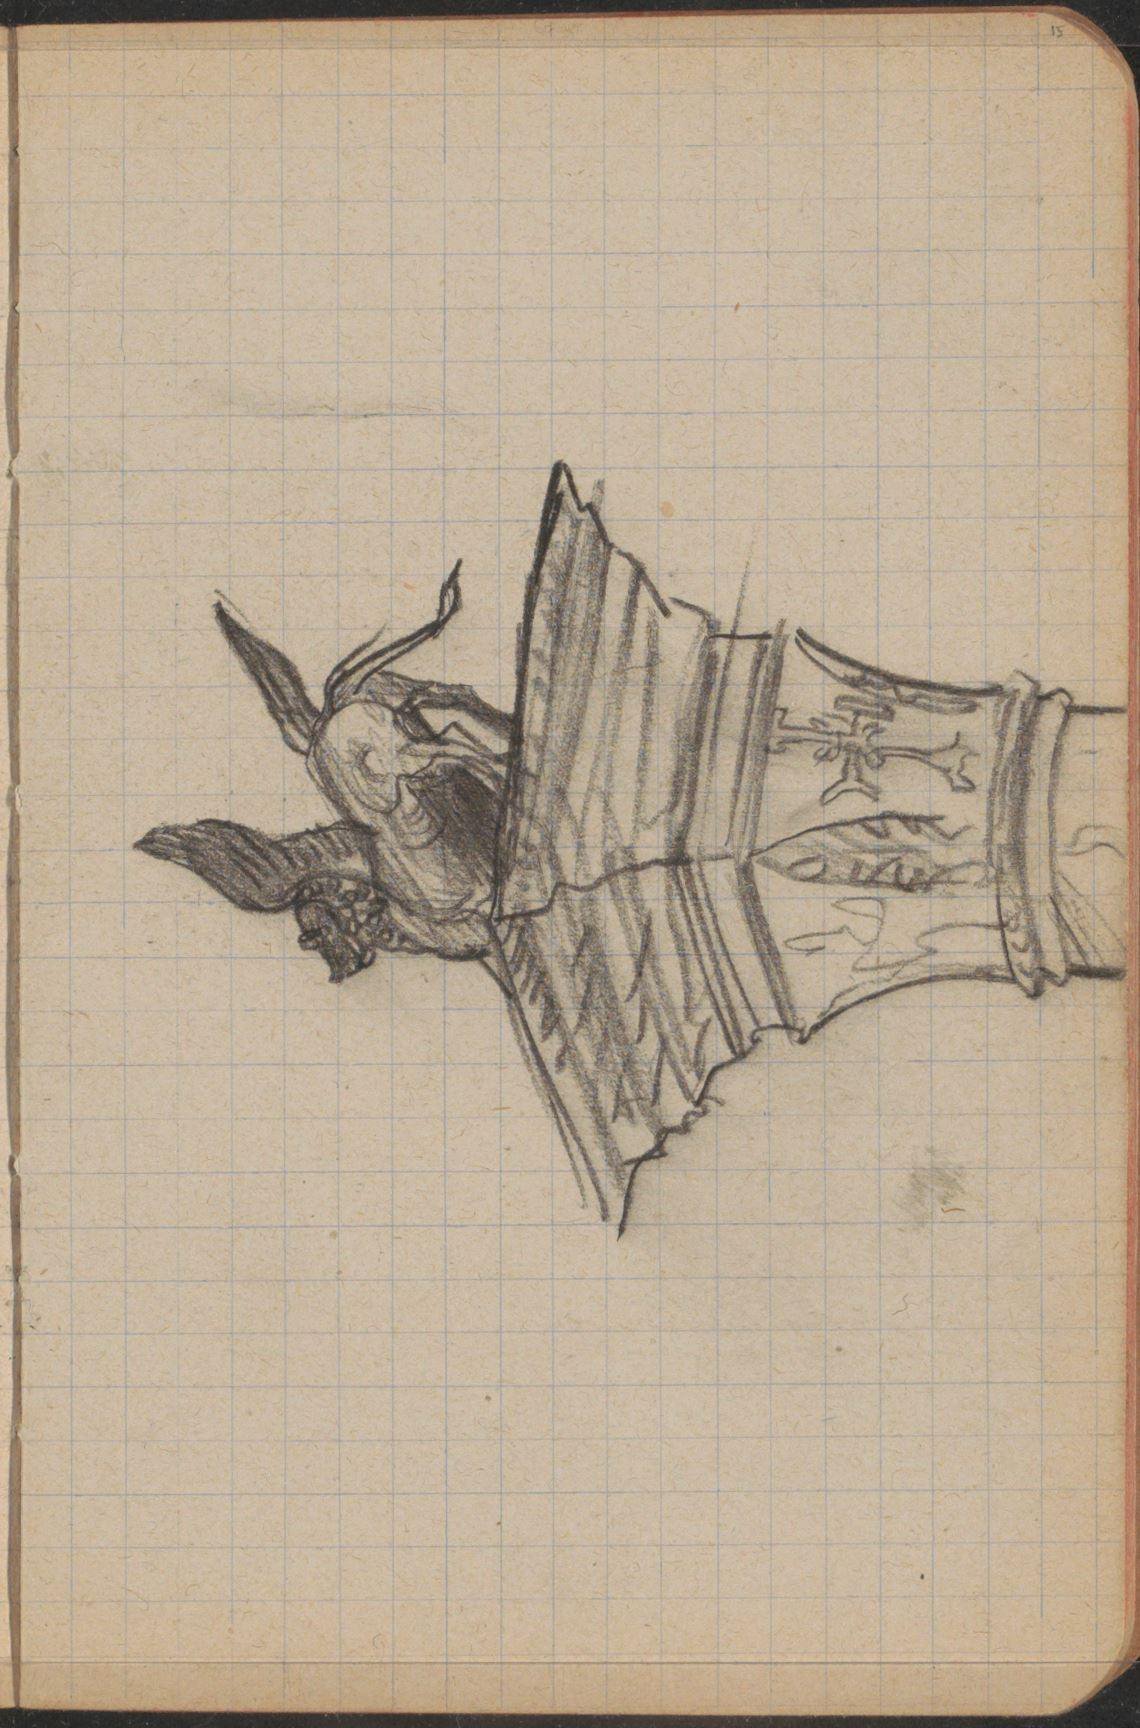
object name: sketchbook leaf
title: Achterzijde van de zuil met het beeld van een gevleugelde leeuw bij het San Marco Plein in Venetië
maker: marius bauer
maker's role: draughtsman, print maker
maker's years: 1867-1932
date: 1895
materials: chalk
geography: venice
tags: column, pillar ~ architecture, sculpture, beasts of prey, predatory animals: lion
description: Pagina 15 uit een schetsboek met 28 bladen.